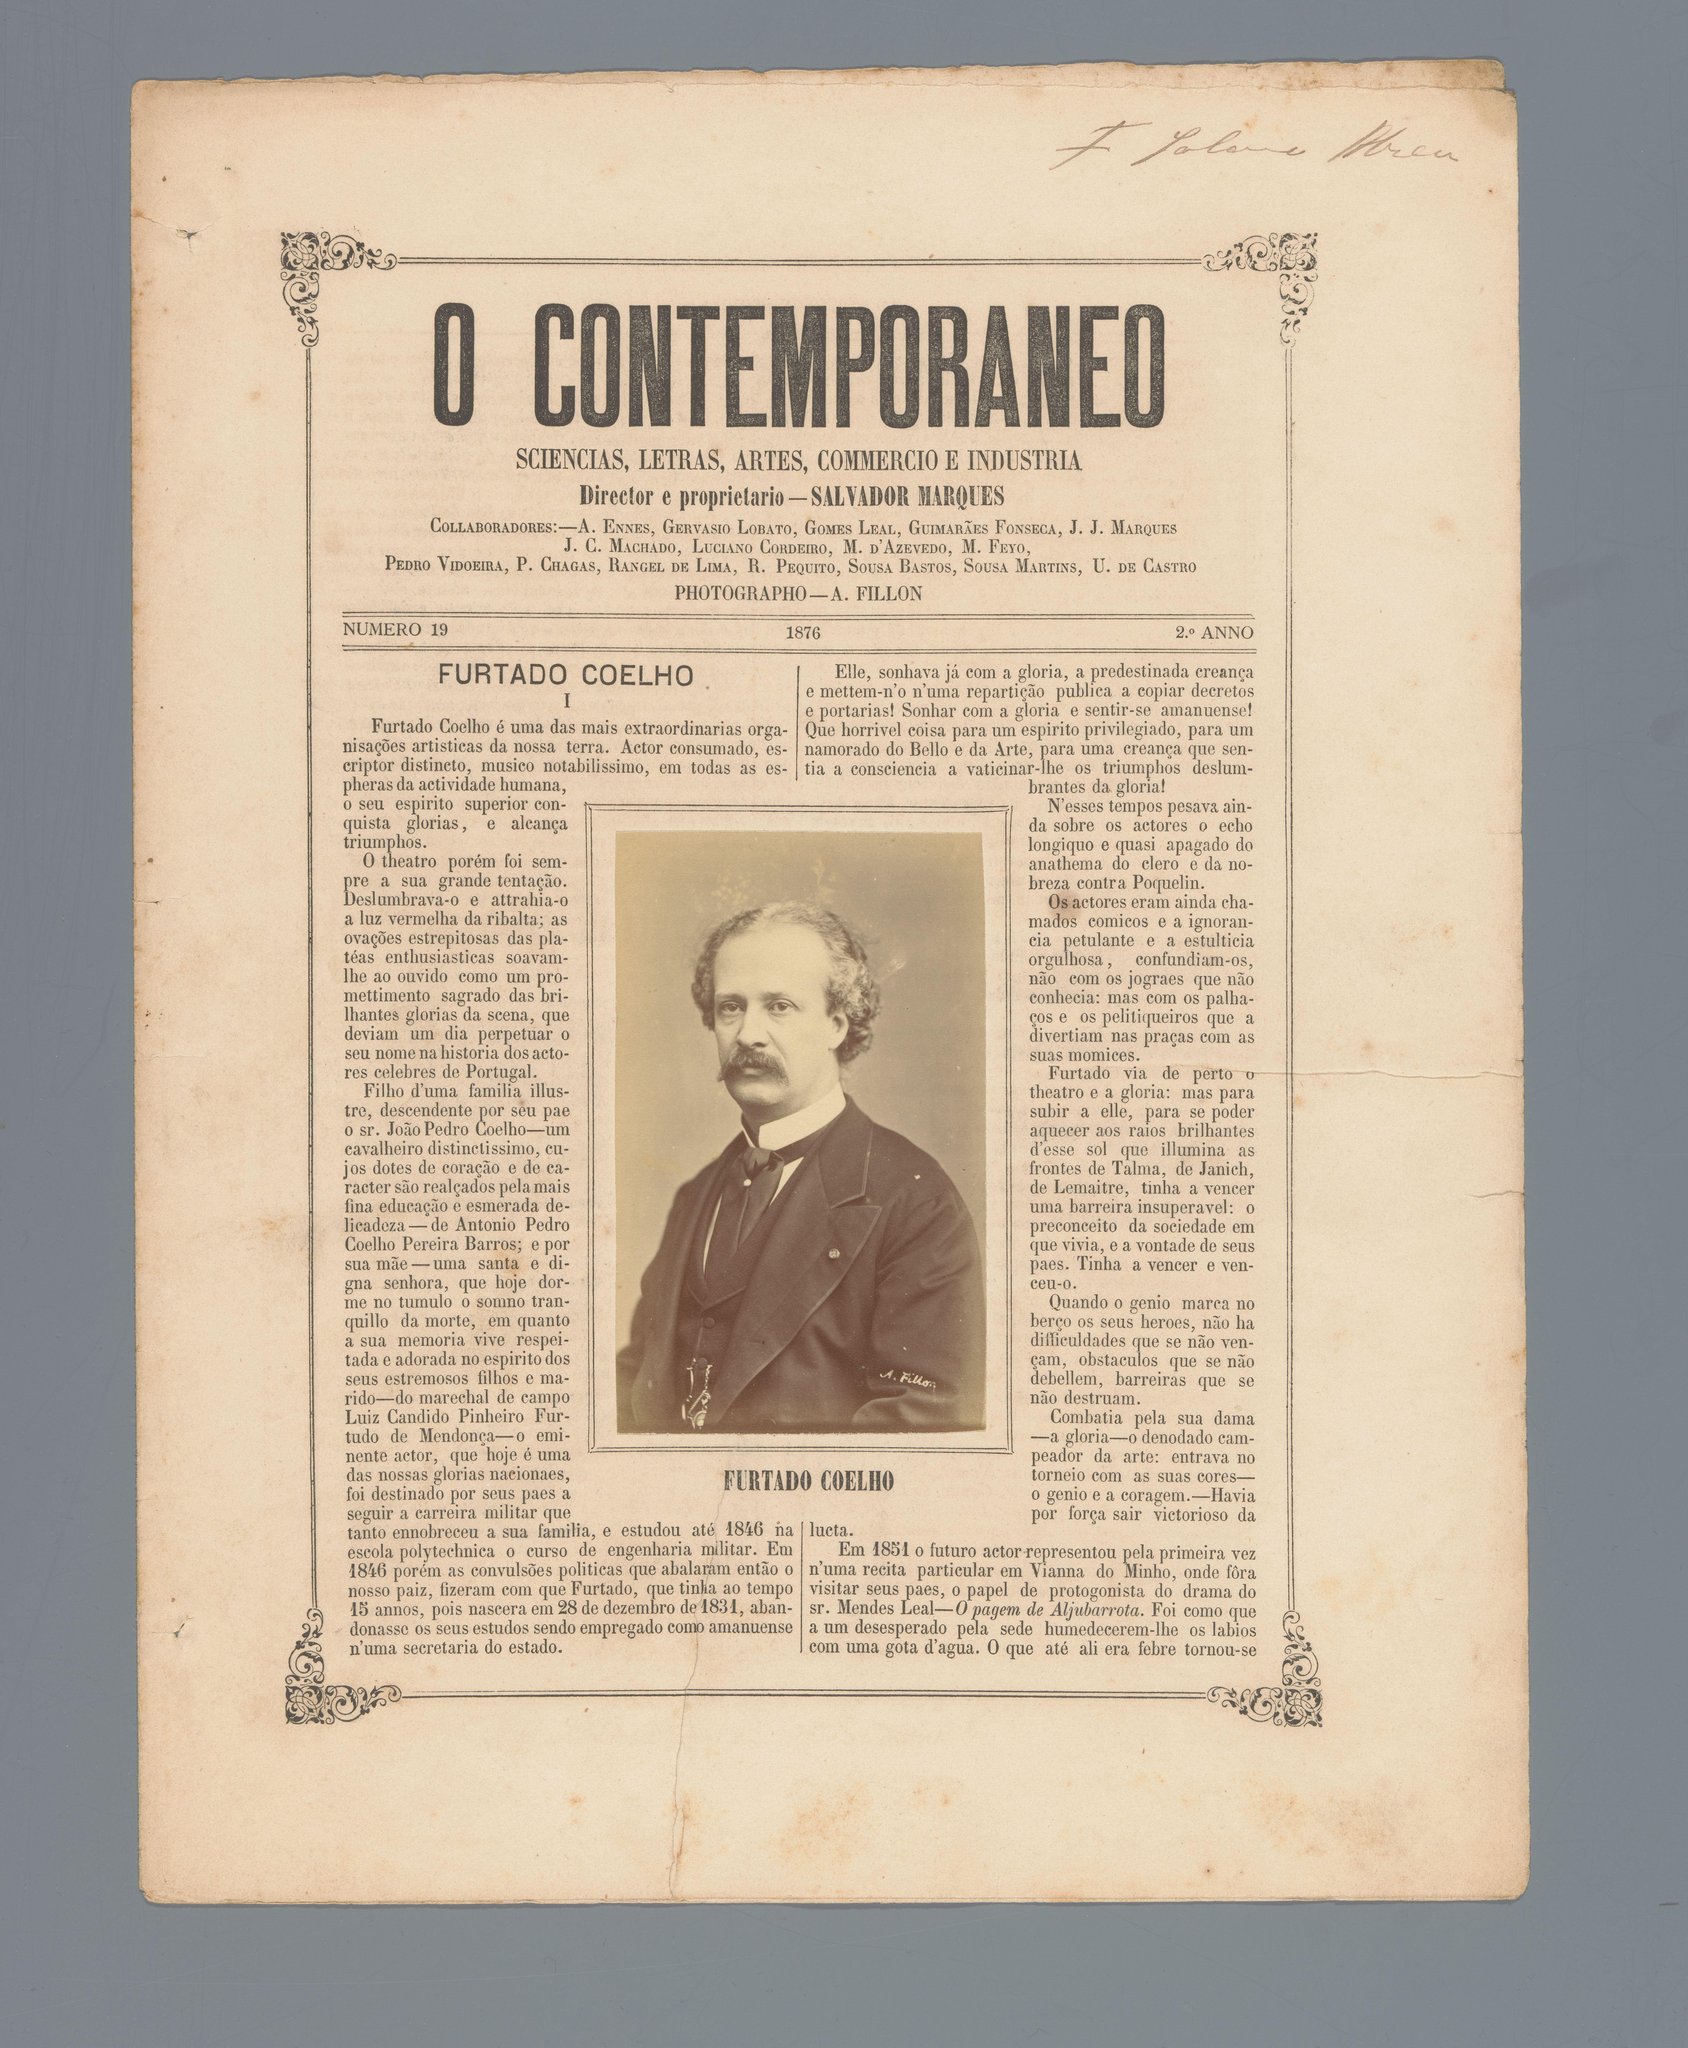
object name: photograph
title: O contemporaneo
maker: alfred fillon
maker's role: fotograaf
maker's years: 1825-1881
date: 1871-1876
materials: paper, photographic support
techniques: albumen print, printing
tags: historical persons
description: Op de voorpagina bevindt zich een portret van Furtado Coelho.